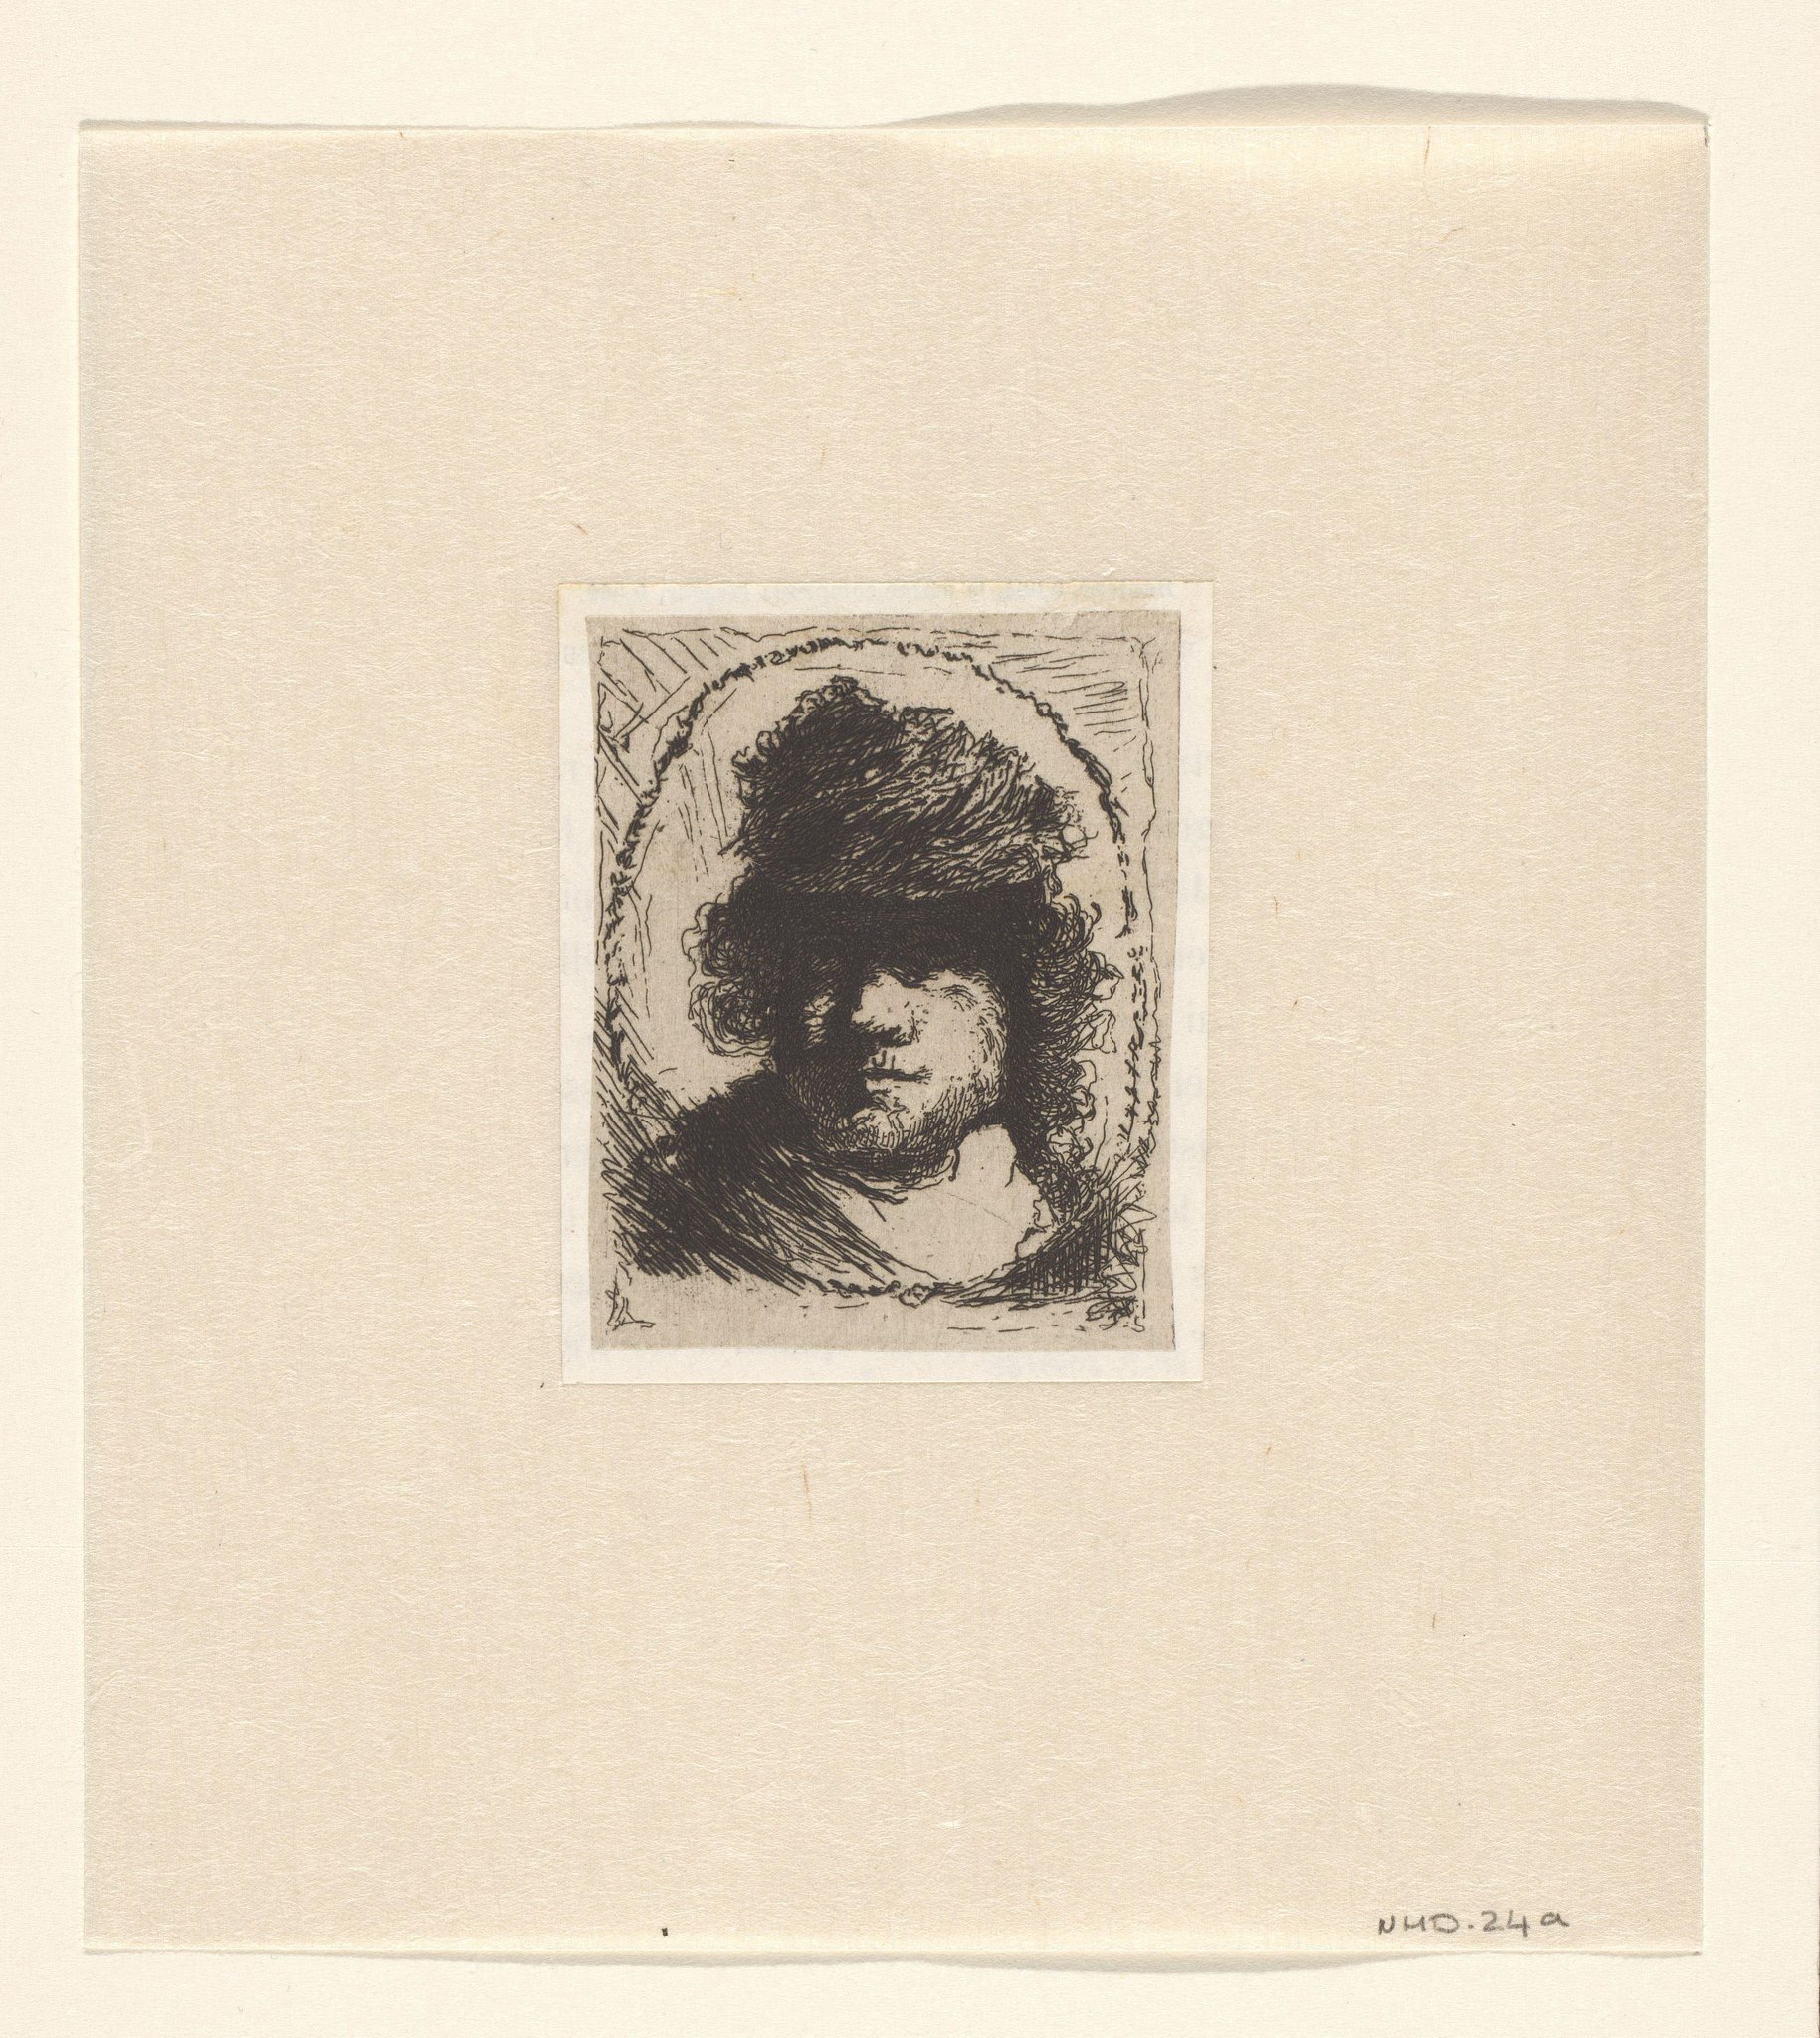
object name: print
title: Self-portrait in a fur cap, in an oval border: bust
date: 1859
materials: paper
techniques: etching, intaglio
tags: leiden, amsterdam, painter, print maker, draughtsman, rembrandt van rijn, portrait, self-portrait of graphic artist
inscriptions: collector's mark: Lugt 2228, collector's mark: Lugt 2760